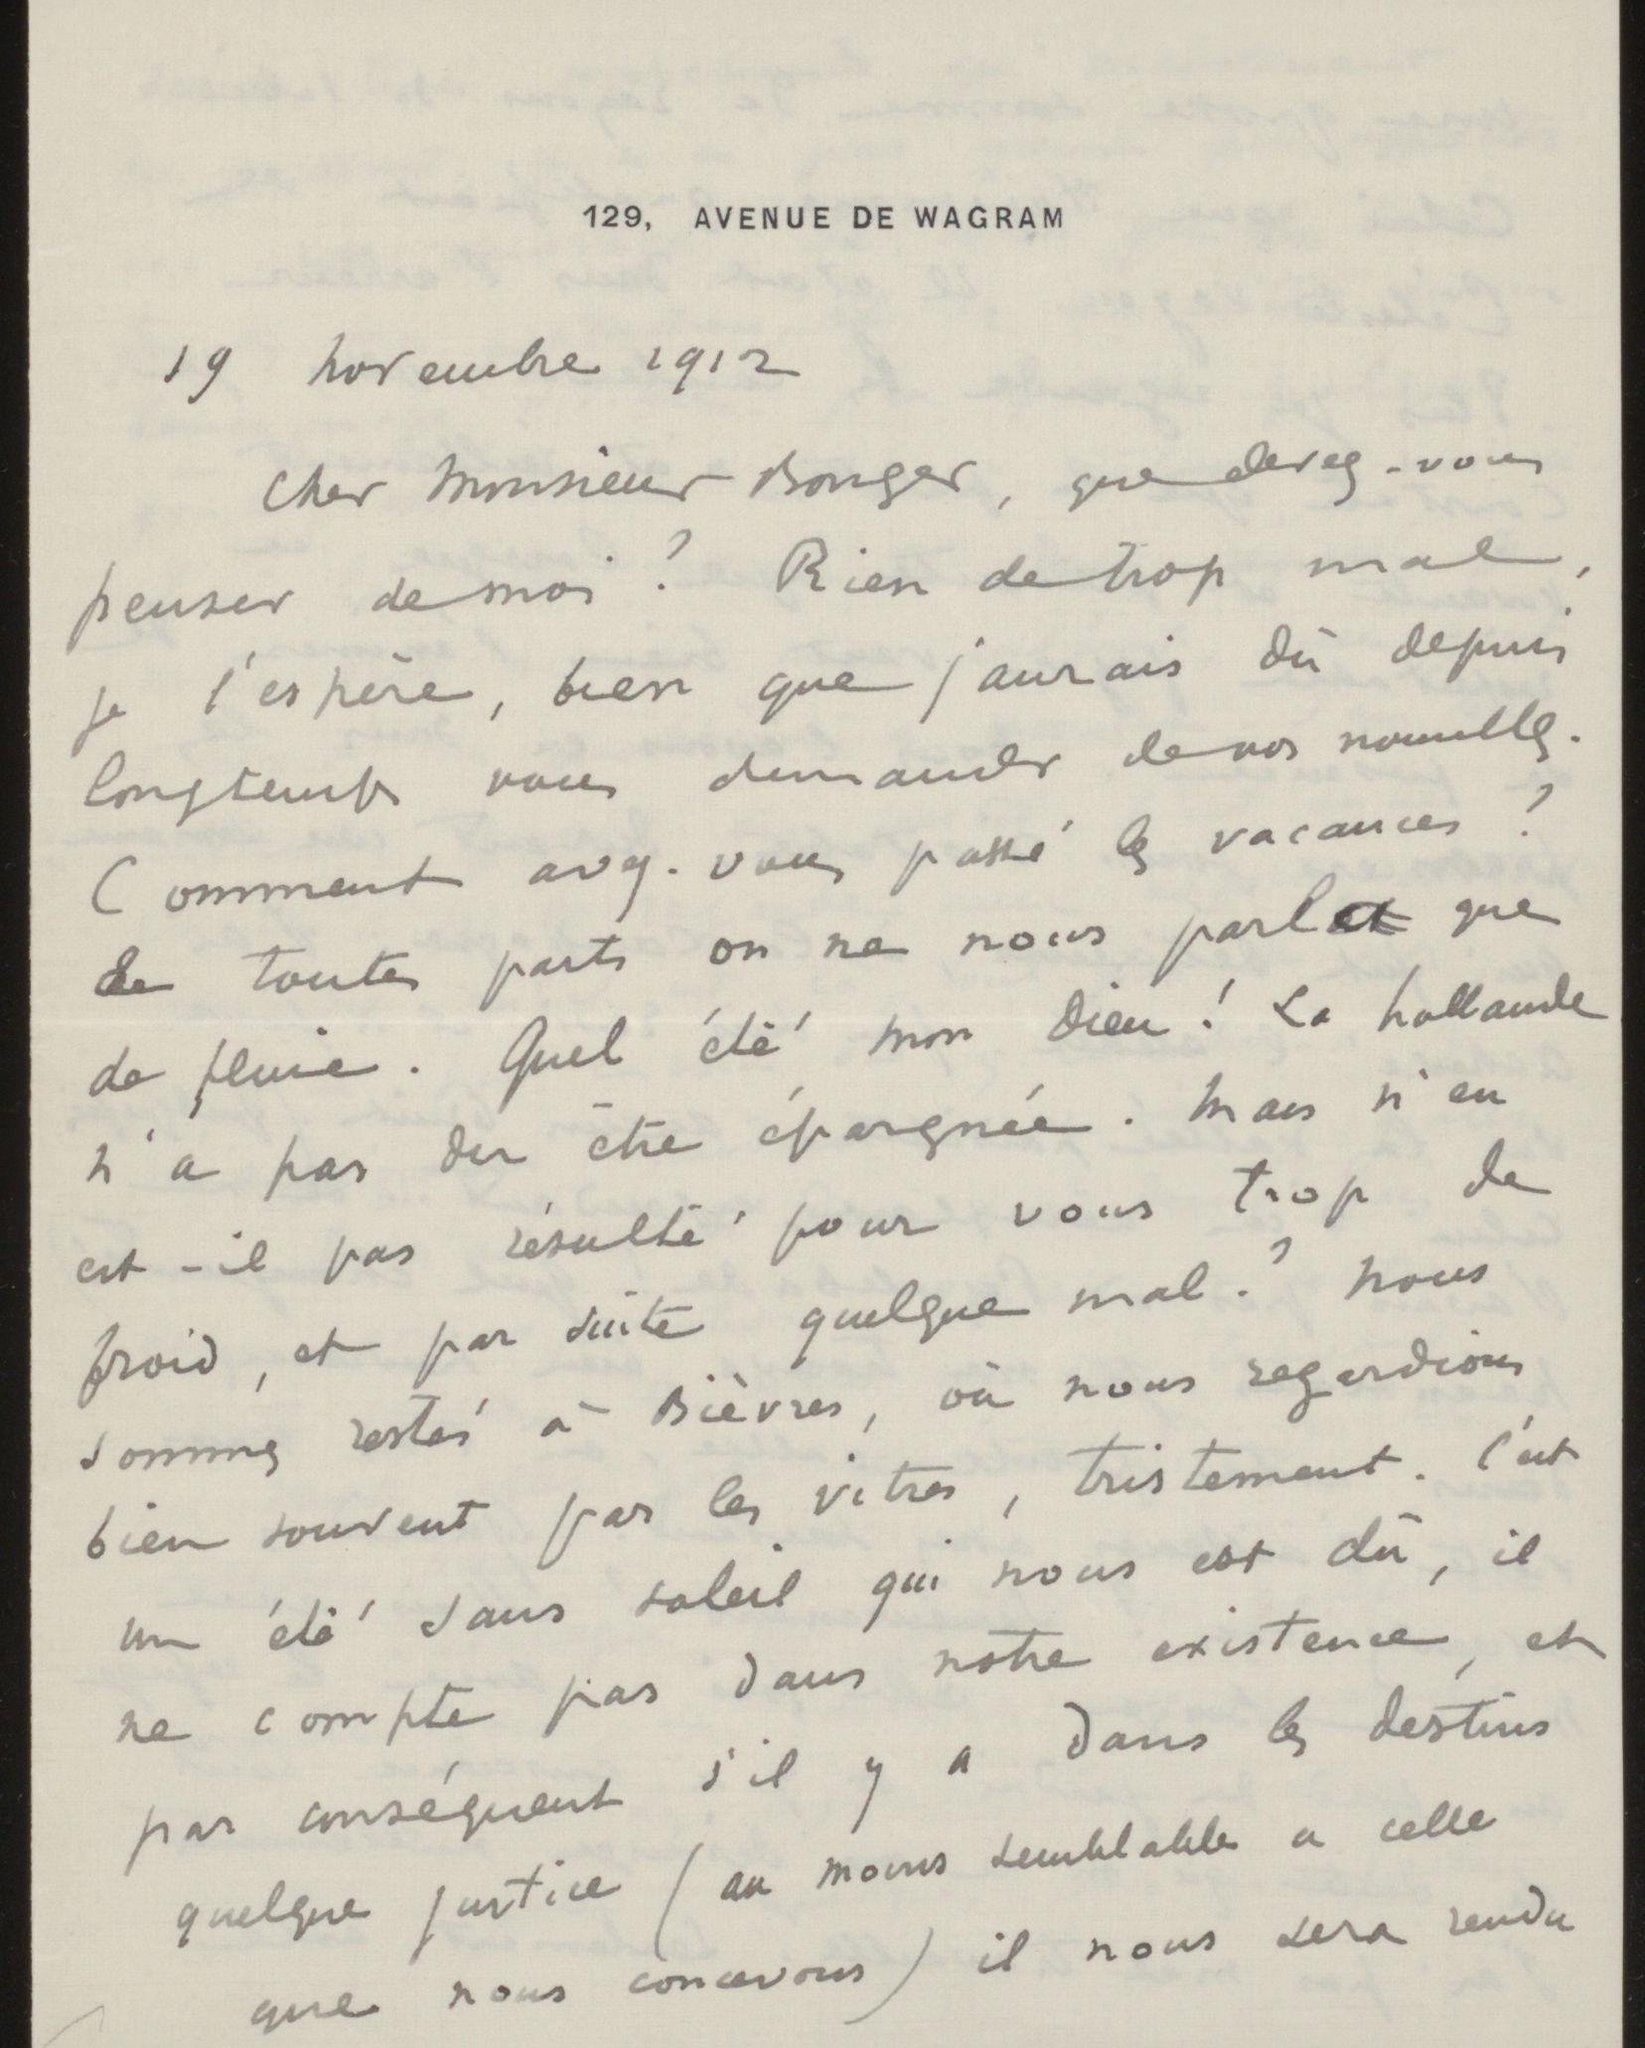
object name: letter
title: Brief aan Andries Bonger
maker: odilon redon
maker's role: draughtsman, painter, print maker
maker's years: 1840-1916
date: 1912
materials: ink, paper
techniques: pen, writing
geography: paris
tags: arï redon, amsterdam, haarlem, publisher, johannes henricus de bois, andries bonger, joris-karl huysmans, drawing, painting (including book-illumination, miniature-painting), printed matter